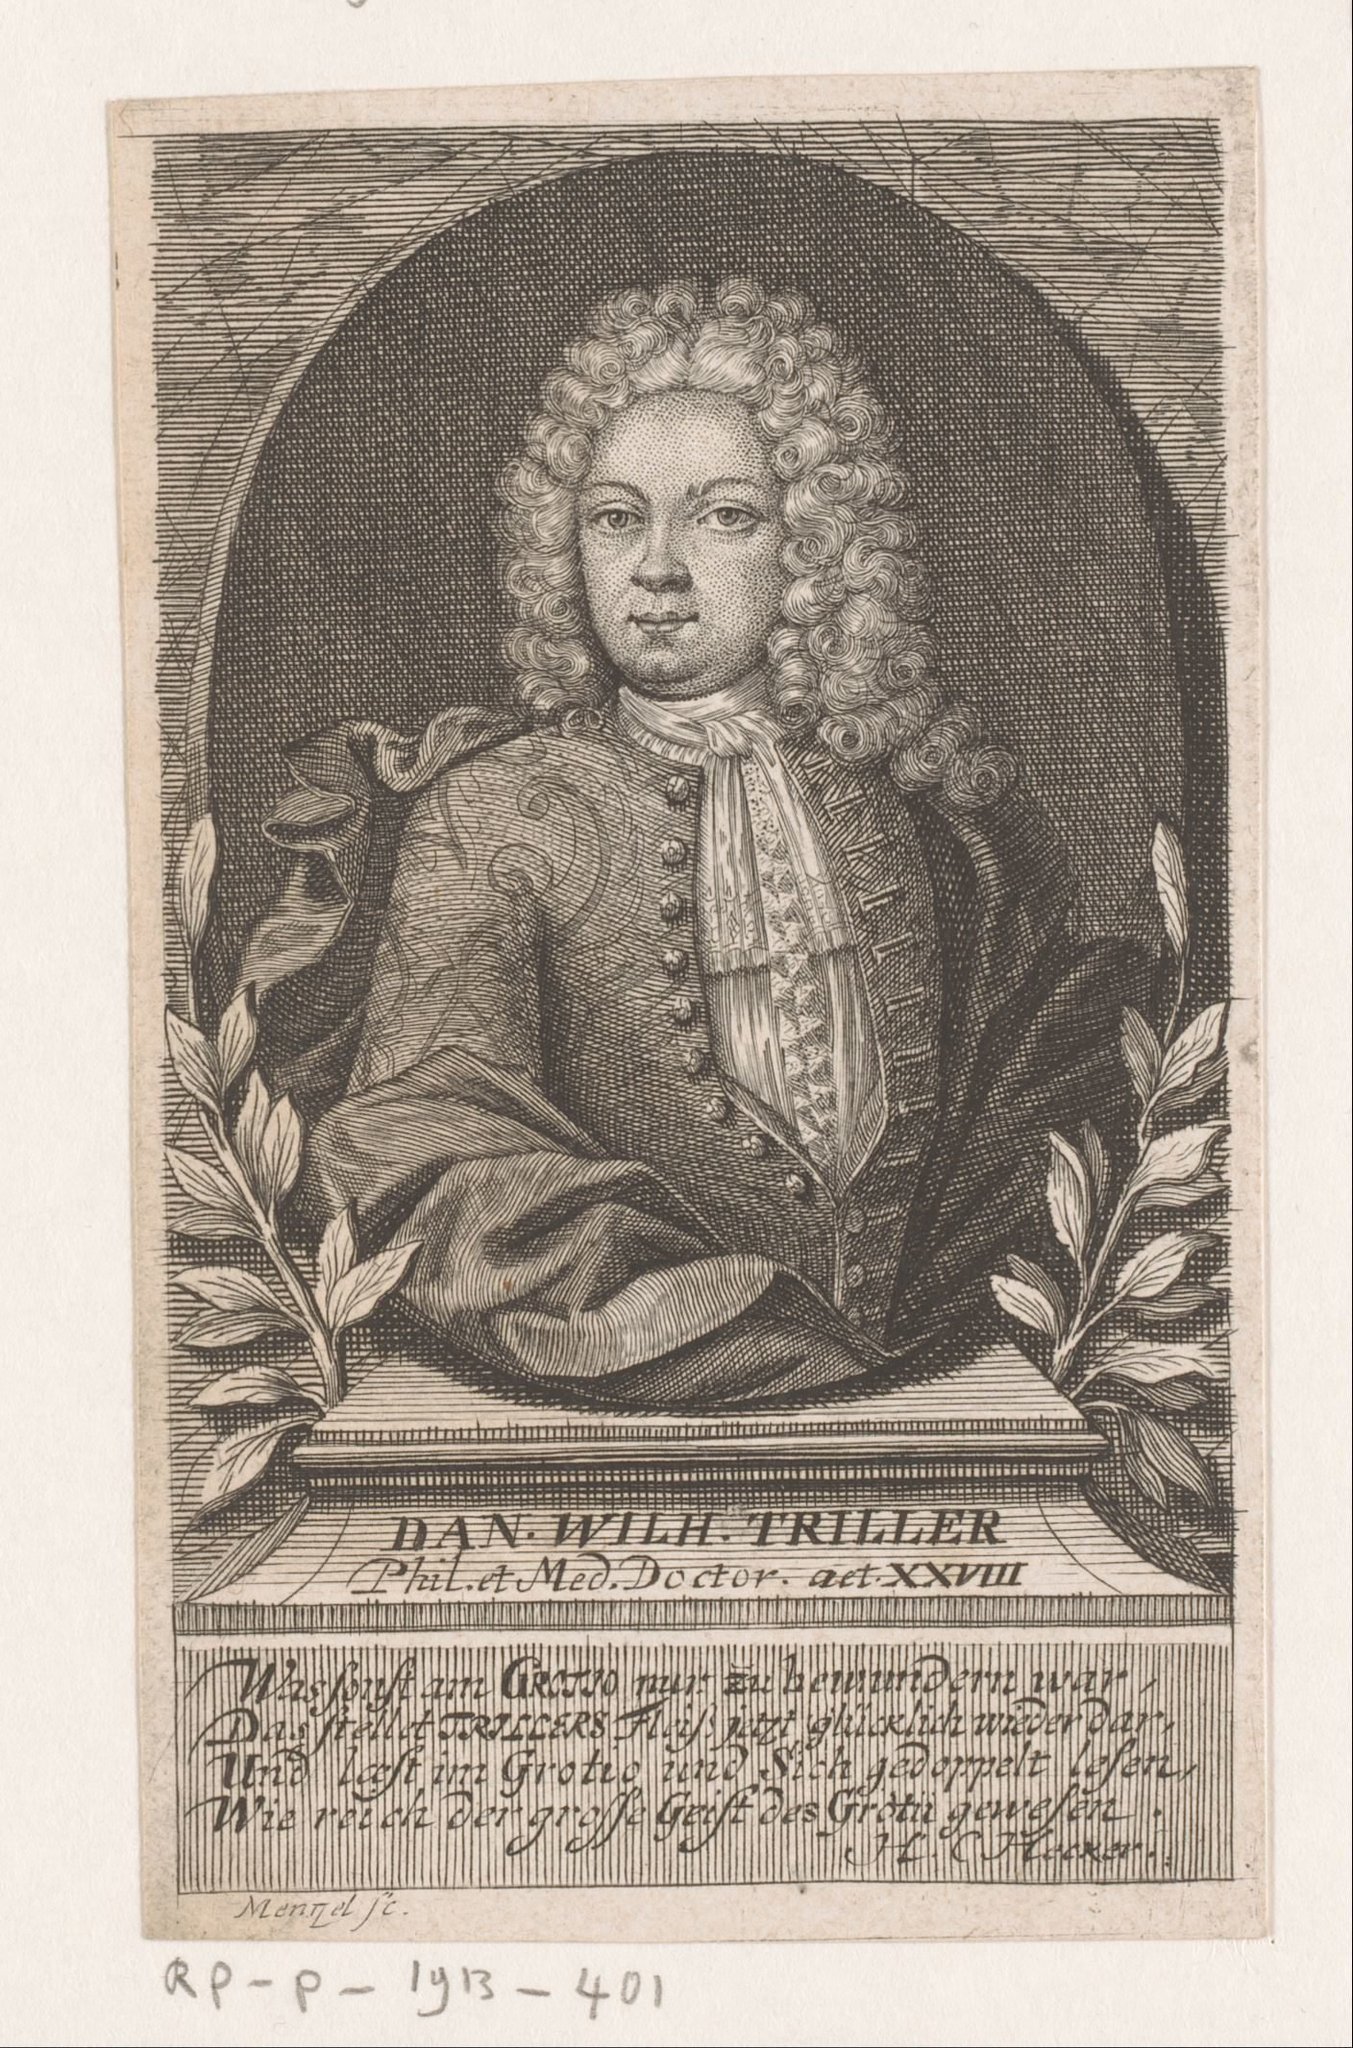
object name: print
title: Portret van Daniel Wilhelm Triller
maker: johann georg mentzel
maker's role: print maker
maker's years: 1677-1743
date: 1710-1743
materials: paper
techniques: engraving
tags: historical persons, wig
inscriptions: collector's mark: Lugt 2228